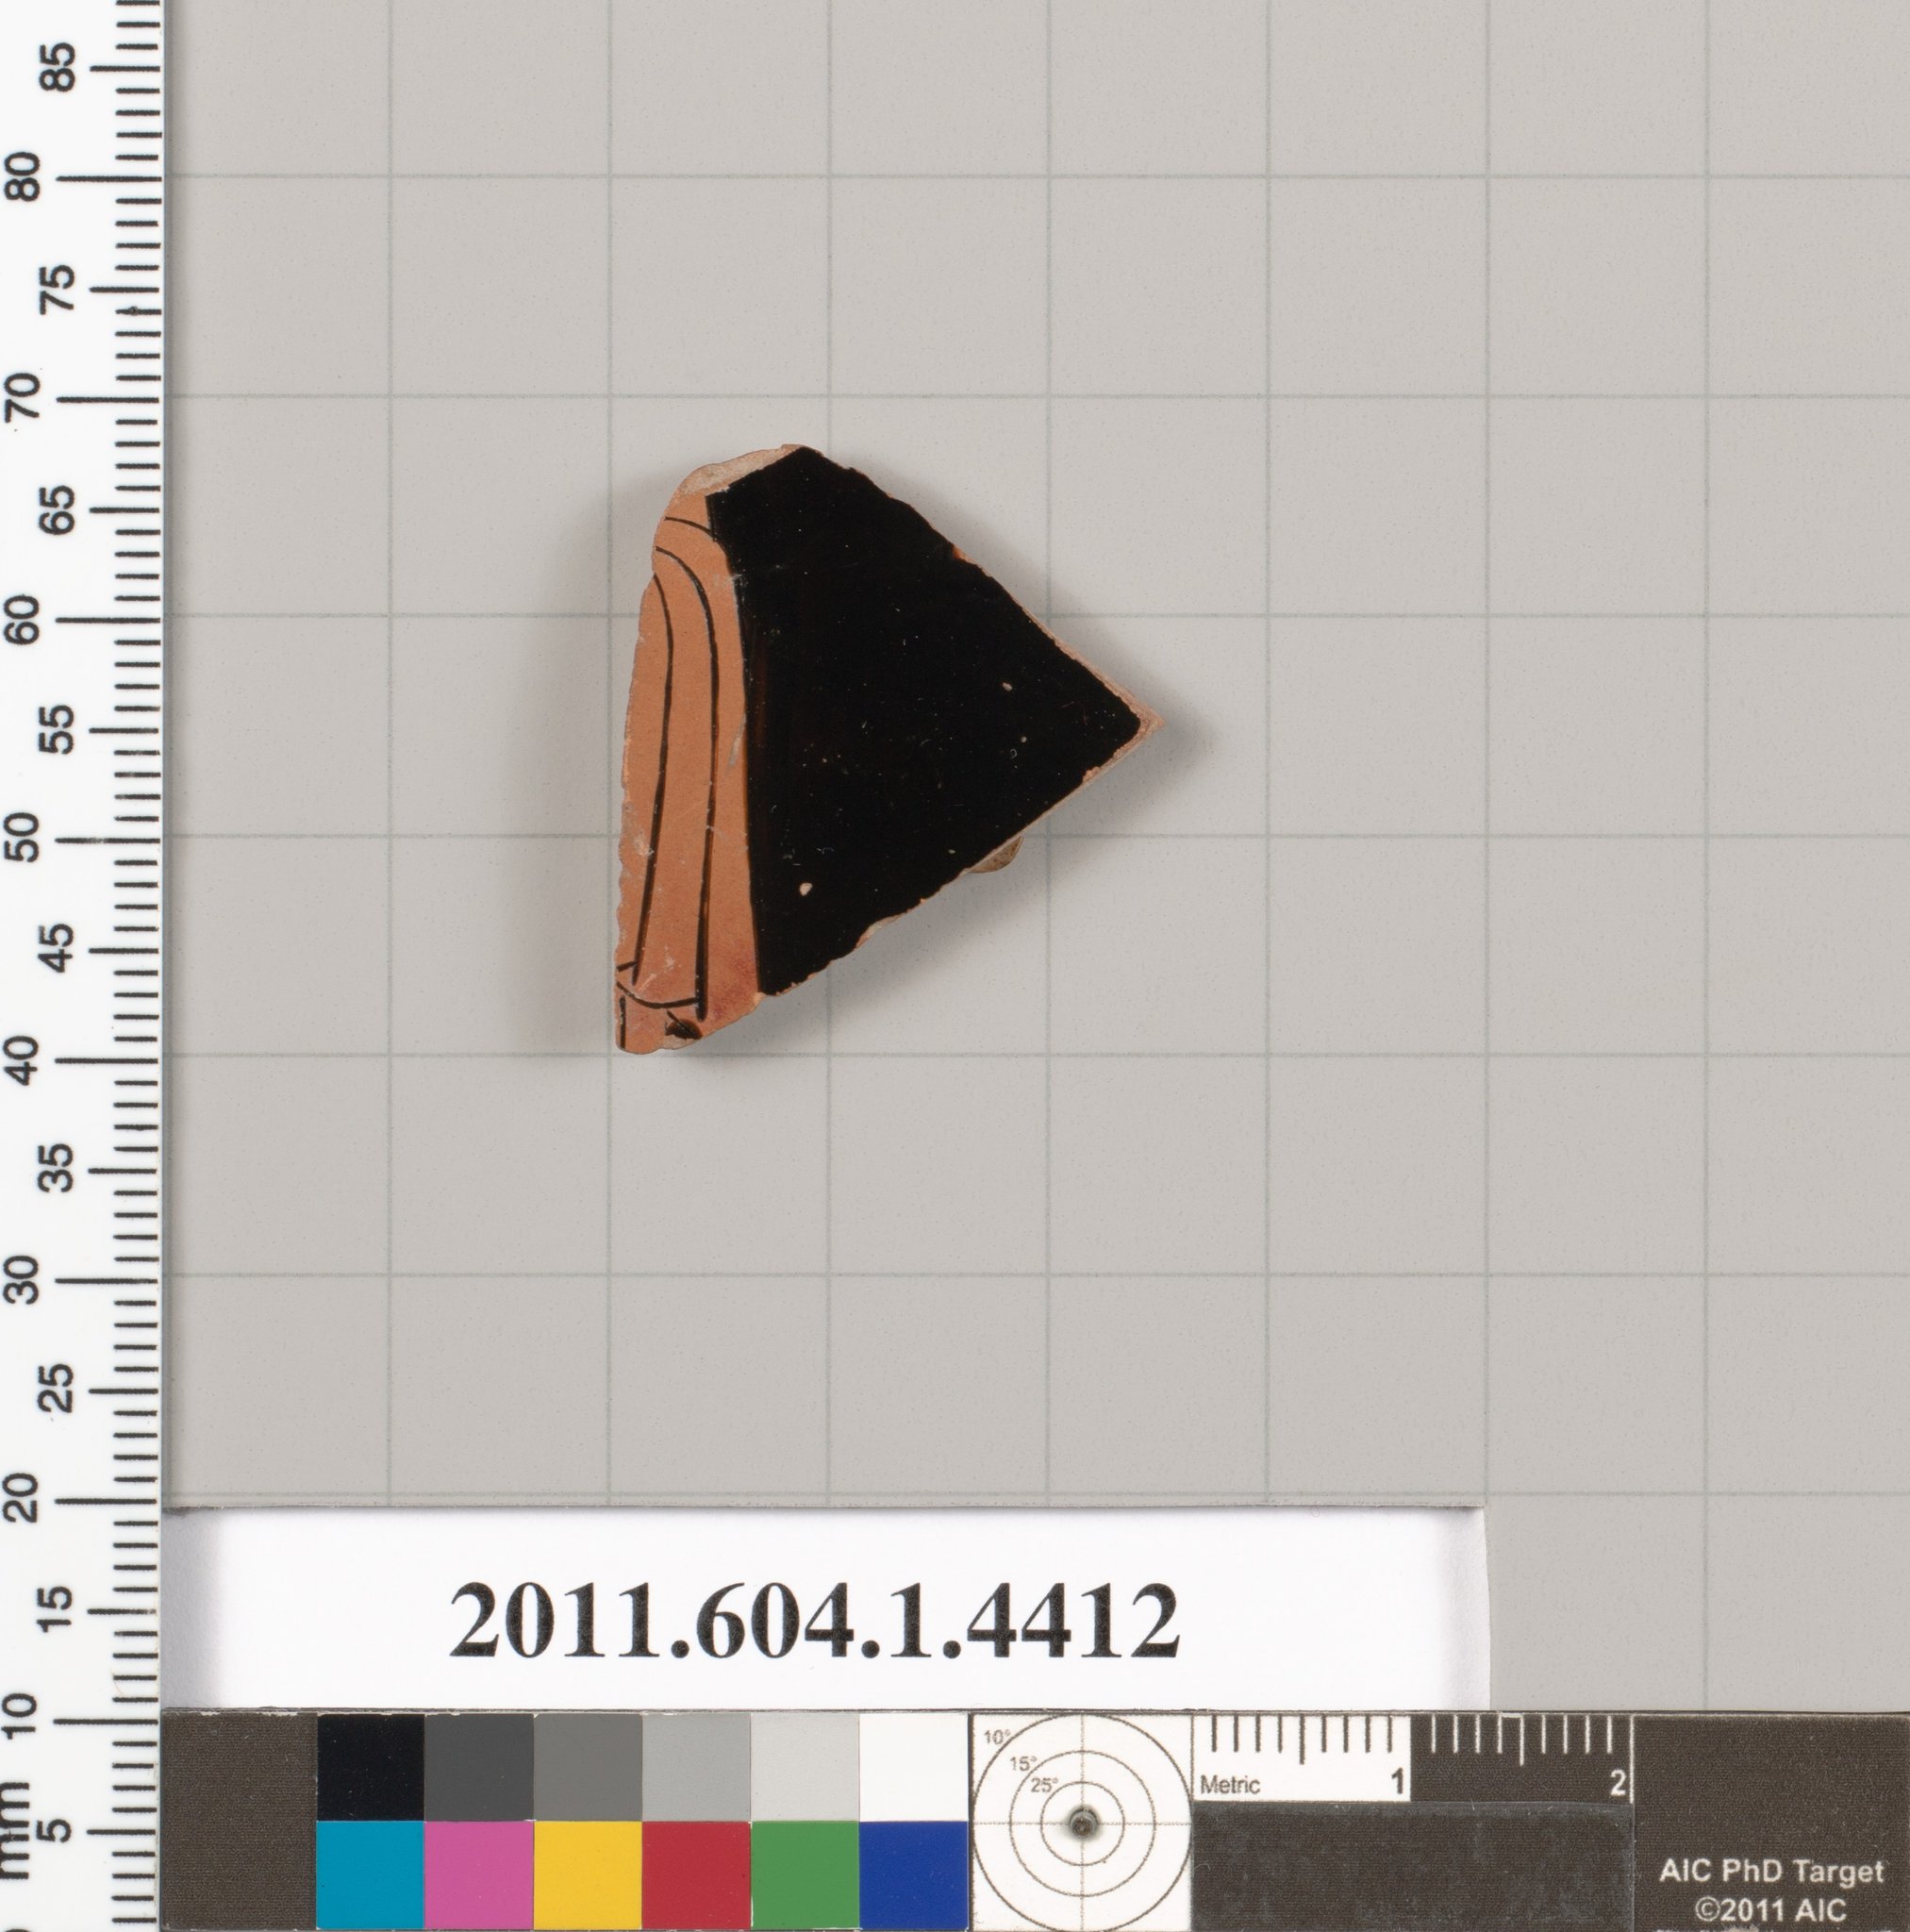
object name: kylix fragment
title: Terracotta fragment of a kylix (drinking cup)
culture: greek, attic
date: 490-470 BCE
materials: terracotta